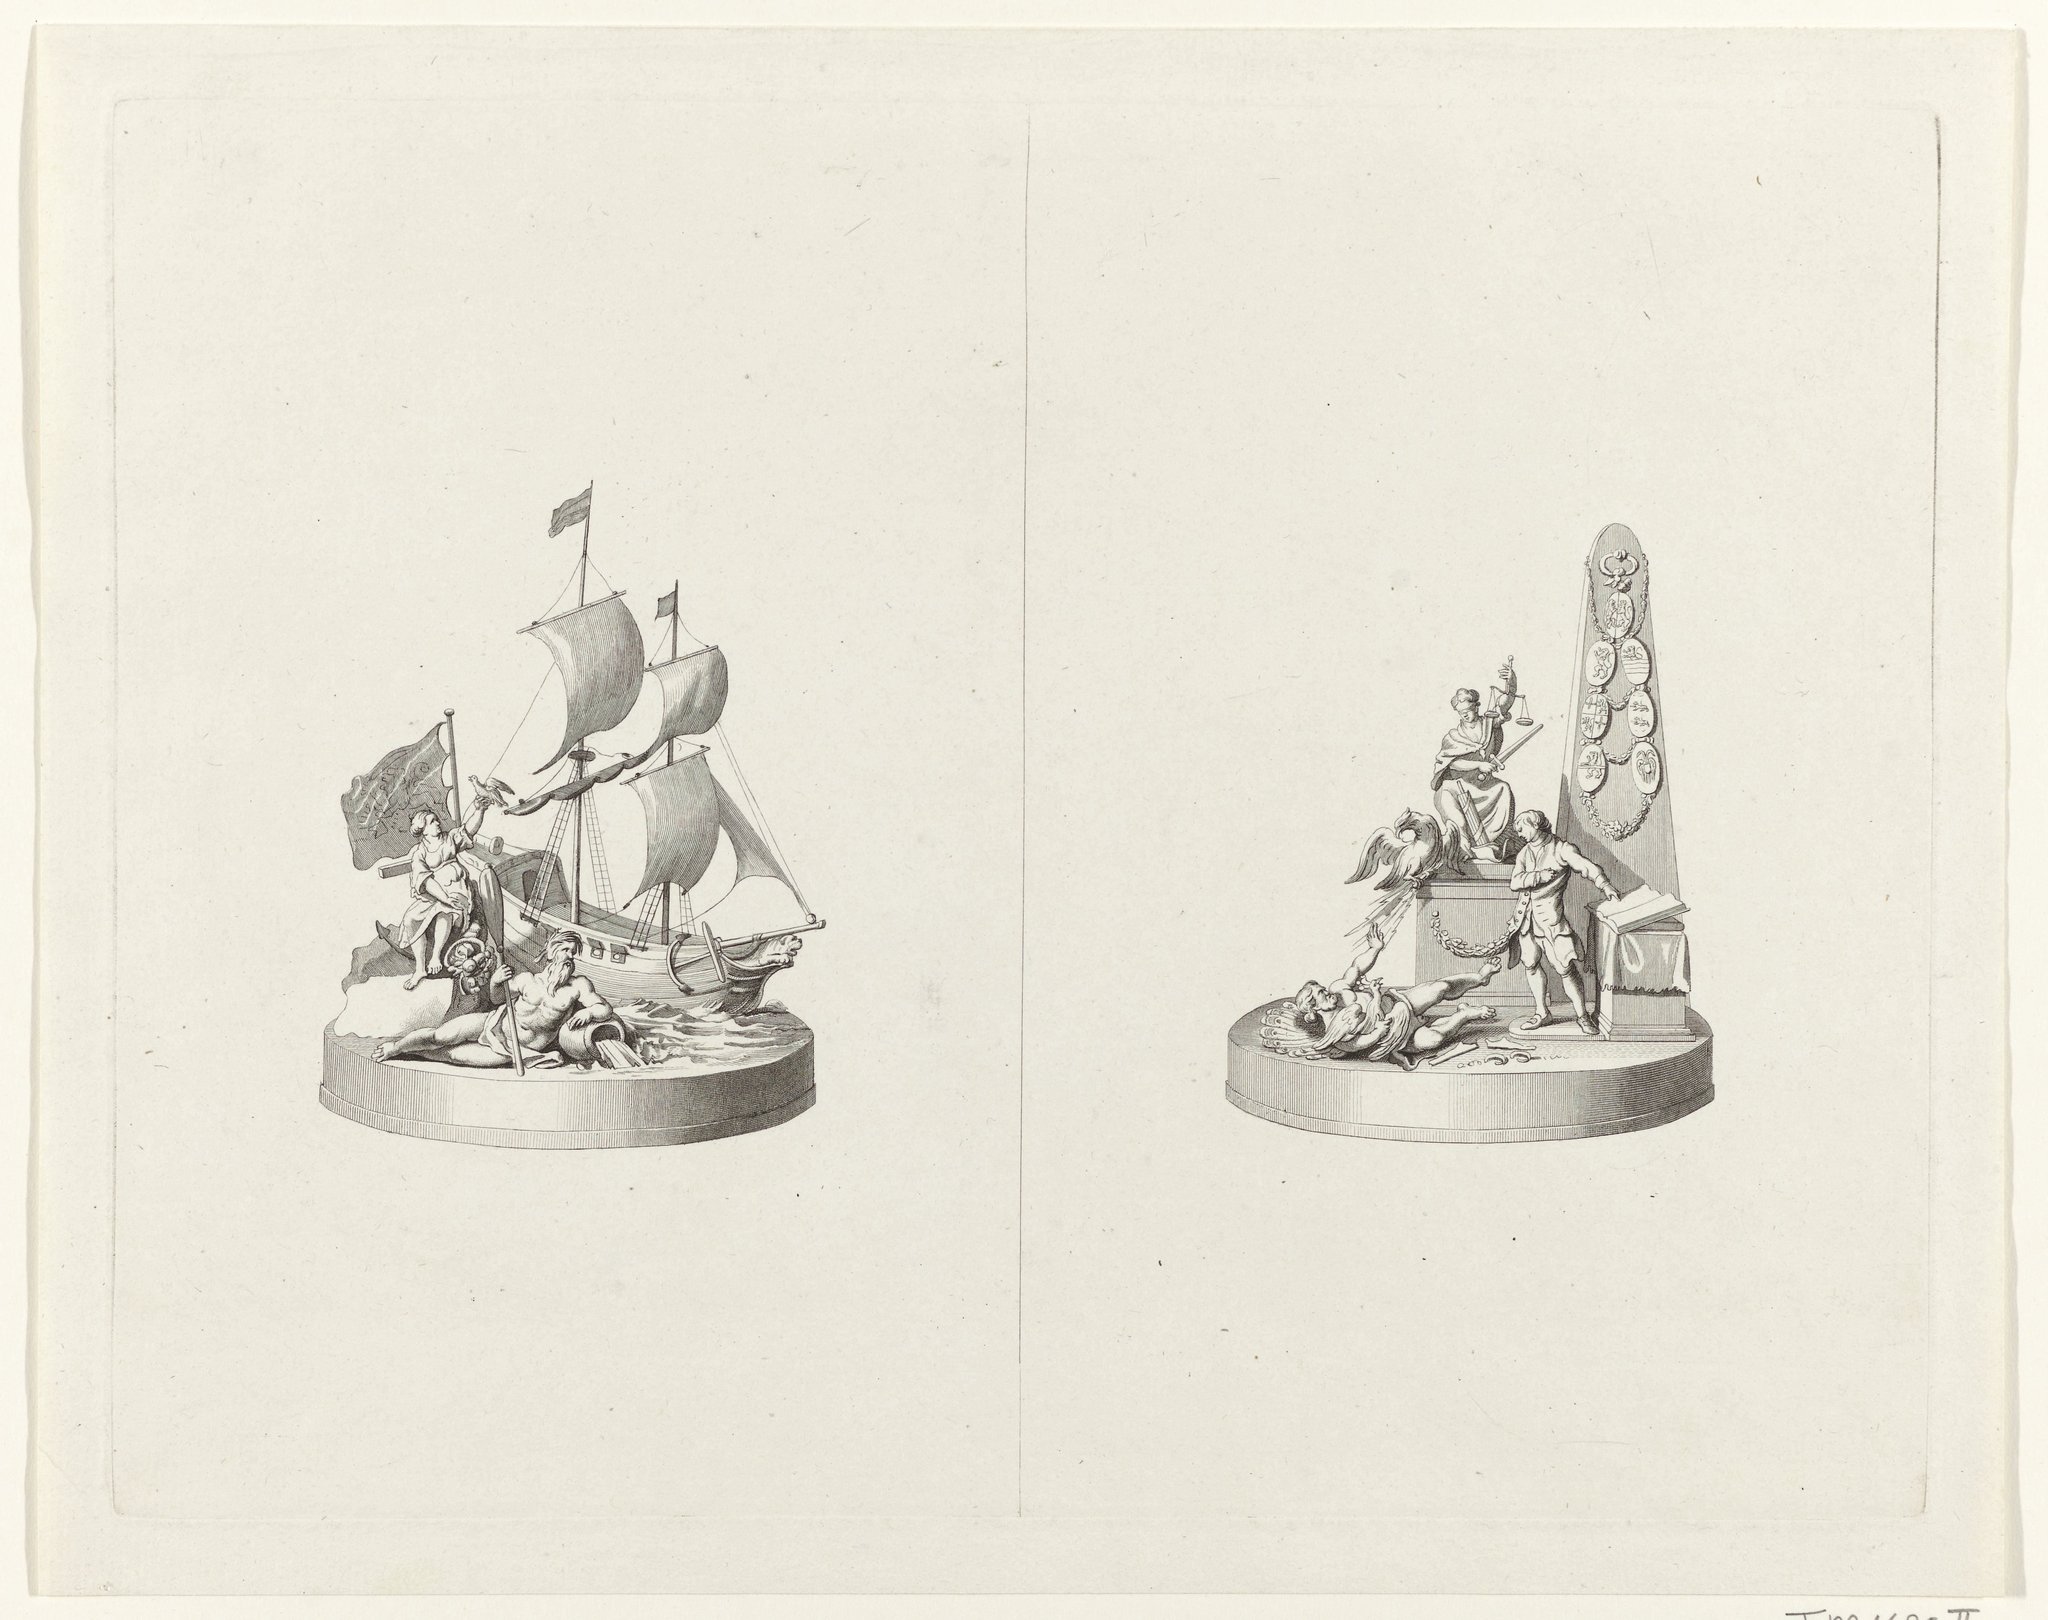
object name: print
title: Twee allegorische tafelversieringen, 1786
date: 1786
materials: paper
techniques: engraving, etching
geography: northern netherlands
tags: festivities on events of national importance (+ eating and drinking ~ festive activities), centre-piece, epergne, 'surtout', 'milieu-de-table', alliance with france (1785)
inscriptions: collector's mark: Lugt 2228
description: Blad met twee allegorische tafelversieringen (milieu de table) gebruikt bij de feestelijke maaltijd gehouden op 27 januari 1786 te Amsterdam om de Alliantie met Frankrijk te vieren. Links "De Vrije Zeevaart": schip met vlag van de Republiek, watergod en de Hoop. Rechts "'s Lands Recht": Gerechtigheid bij een zuil met de zeven provinciewapens, Hoogmoed ligt op de grond.